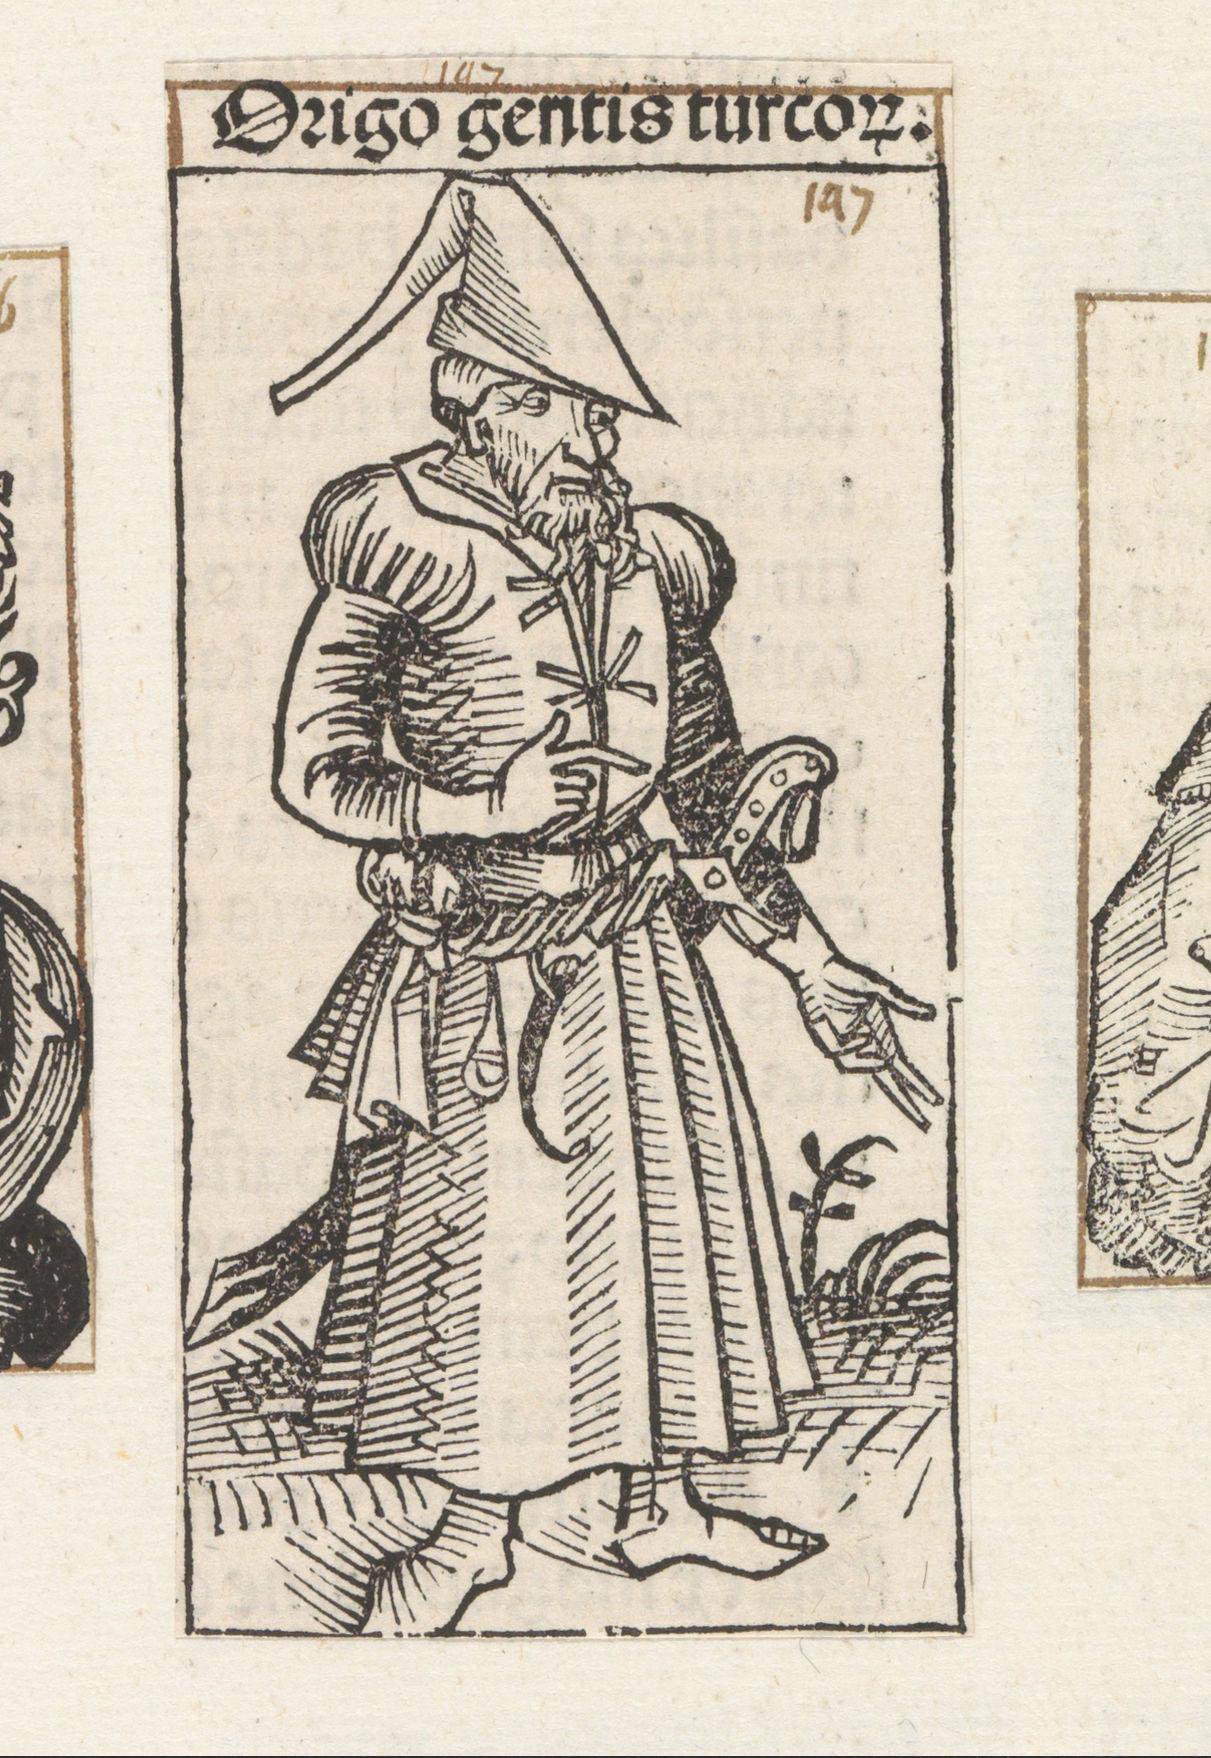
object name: book illustration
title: Turkse man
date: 1493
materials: paper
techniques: letterpress printing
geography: nuremberg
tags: human races, peoples and nationalities (other than prehistoric or extinct)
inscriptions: inscription: ‘147 / 147’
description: De houtsnede wordt herhaaldelijk gebruikt als boekillustratie in de Liber Chronicarum (of Neurenbergkroniek) van Hartmann Schedel, verschenen in het Latijn en Duits in 1493. Zie de Latijnse uitgave, folio 165r.